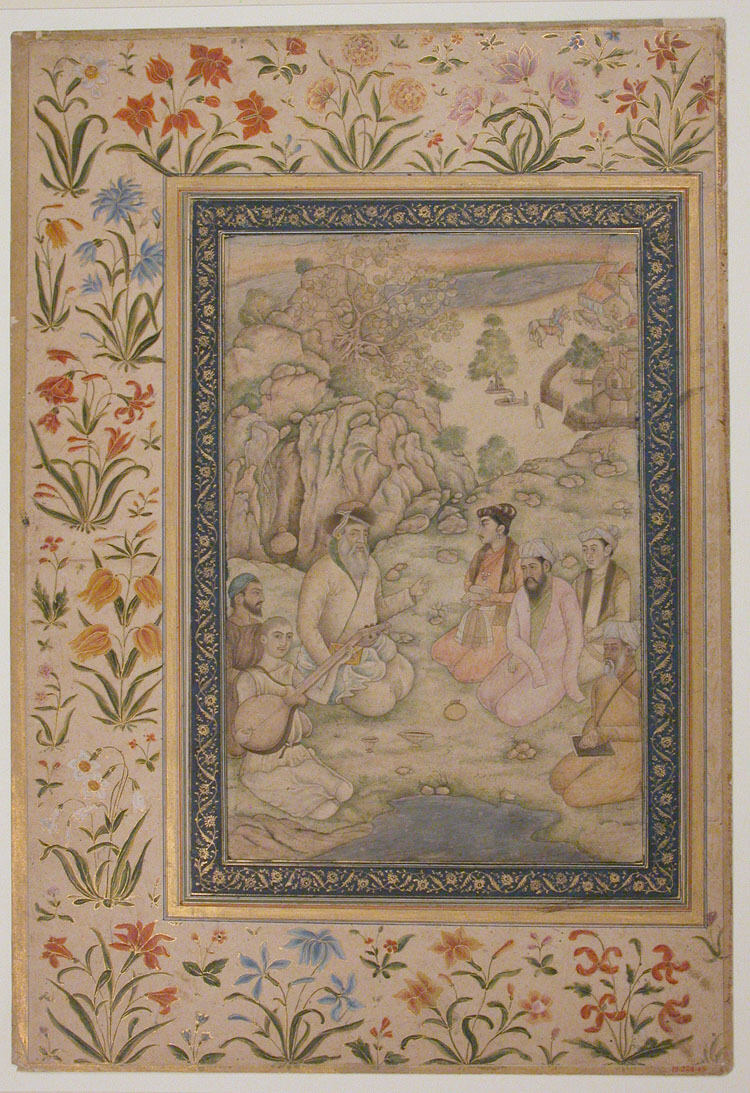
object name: album leaf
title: Jahangir Visiting a Holy Man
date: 1801-1900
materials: gold, ink, paper, watercolor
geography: india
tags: musical instruments,kings,men,flowers,landscapes,leaves